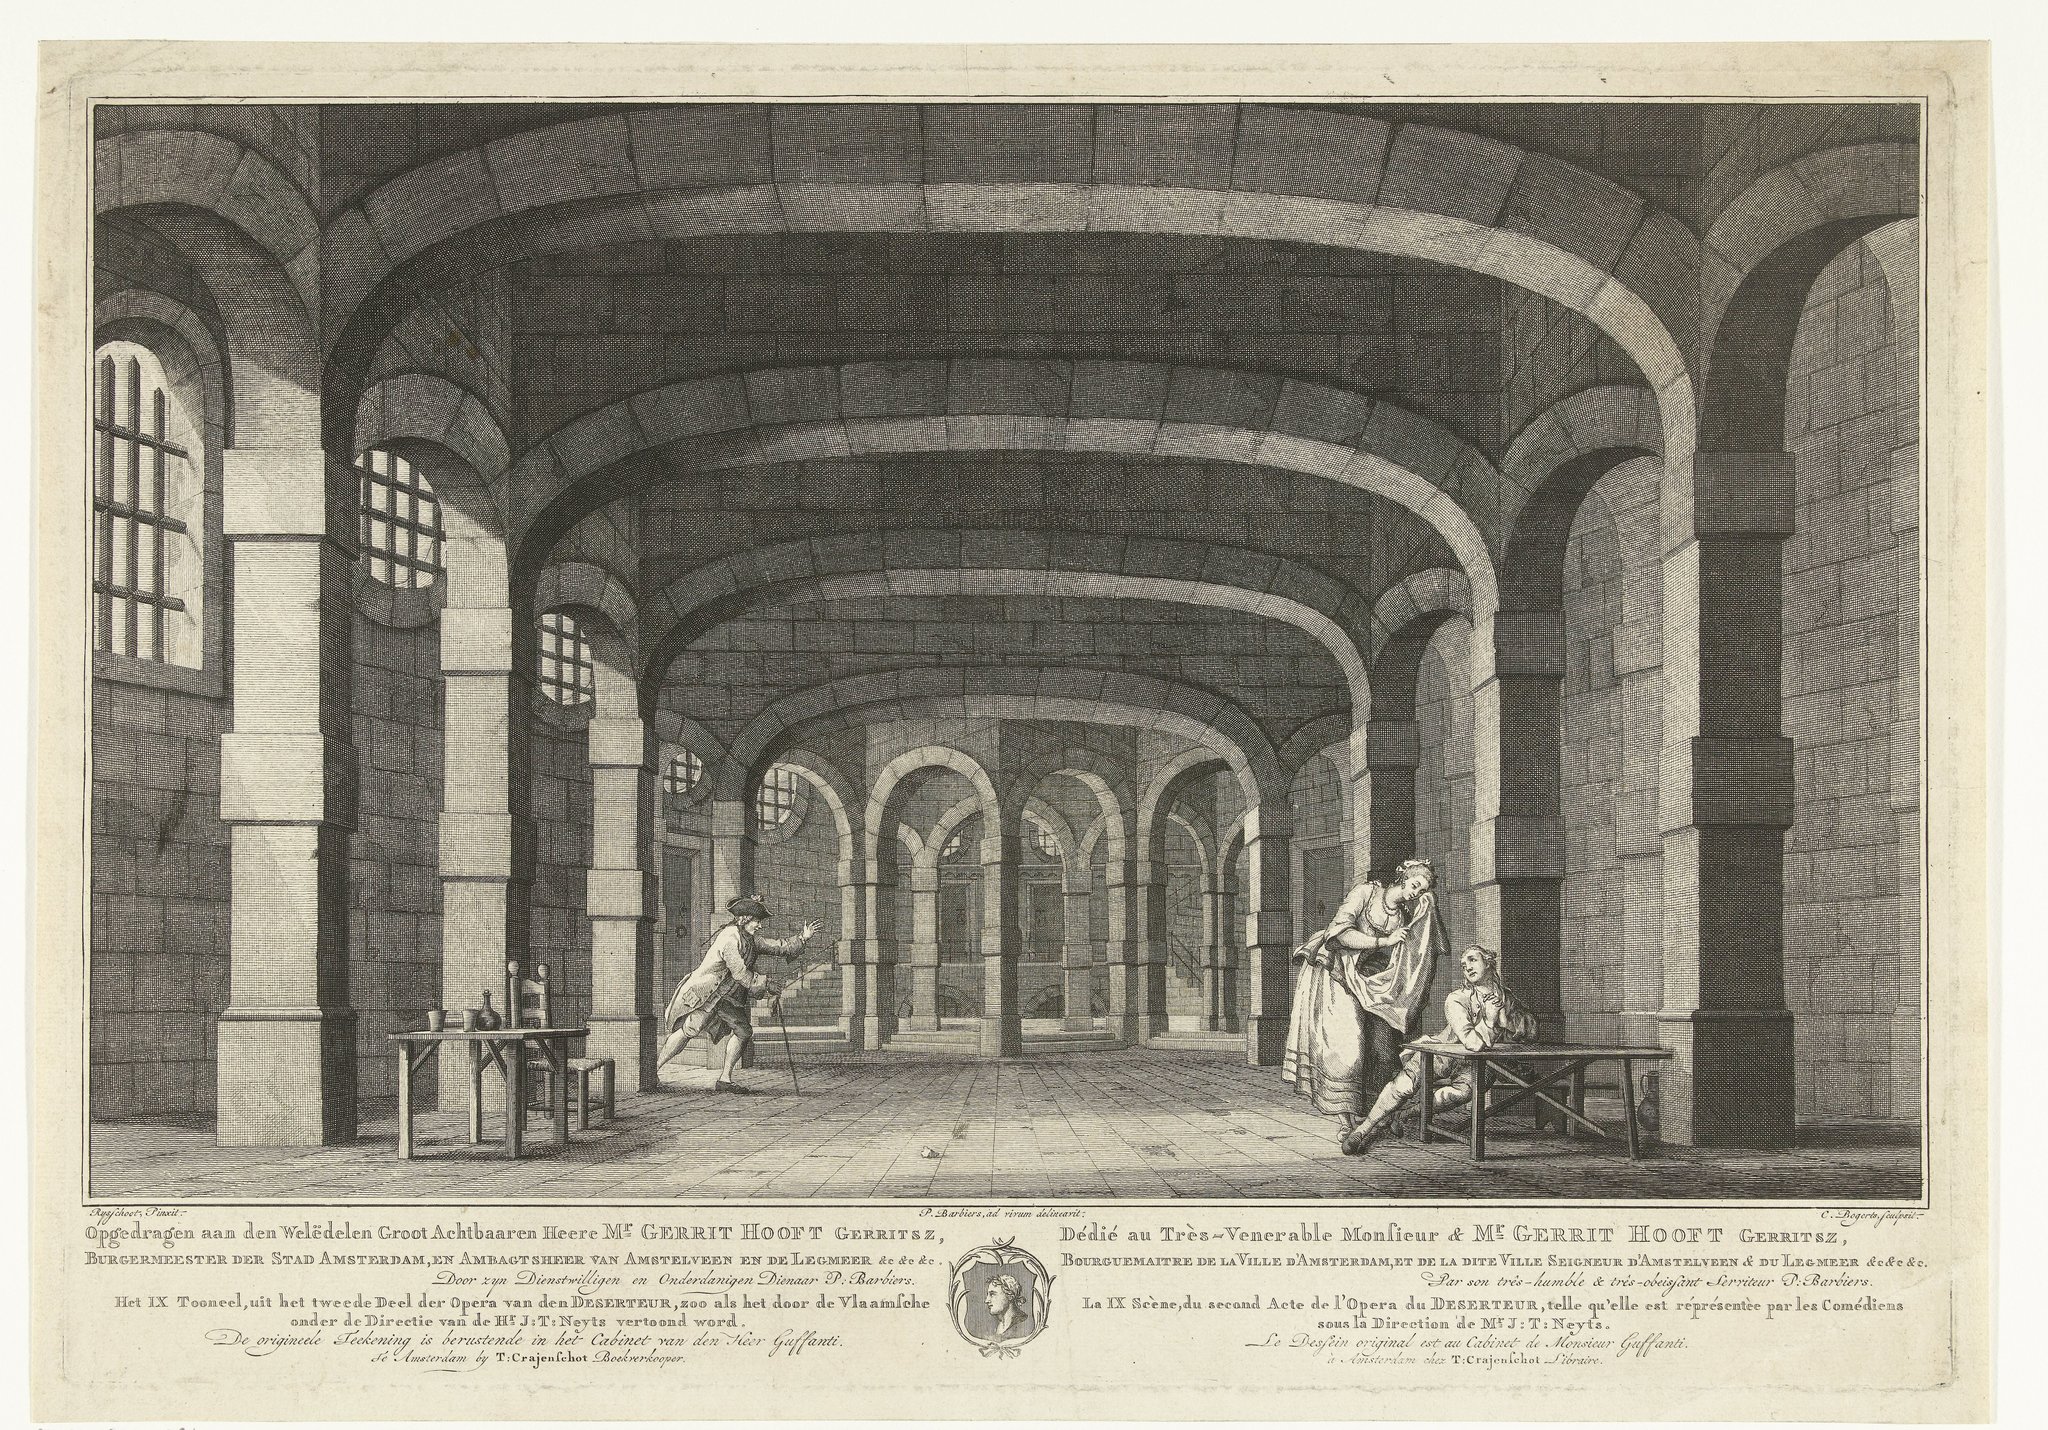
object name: print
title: Scène uit de opera De Deserteur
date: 1772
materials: paper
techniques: engraving, etching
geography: amsterdam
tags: mayor, gerrit gerritsz. hooft, opera, armorial bearing, heraldry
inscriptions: collector's mark: Lugt 2228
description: Opgedragen aan burgemeester Gerrit Gerritsz. Hooft, die in november 1767 overleed. Deze opera, die in 1769 voor het eerst werd opgevoerd in Parijs, ging echter pas in 1772 in Amsterdam in première onder de directie van Jacques Toussaint Neyts. De enige andere Gerrit Hooft die burgemeester is geweest was zijn vader, die reeds in 1717 was overleden.